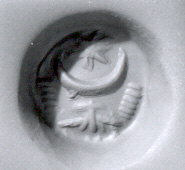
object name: stamp seal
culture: sasanian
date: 201-700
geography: iran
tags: stars